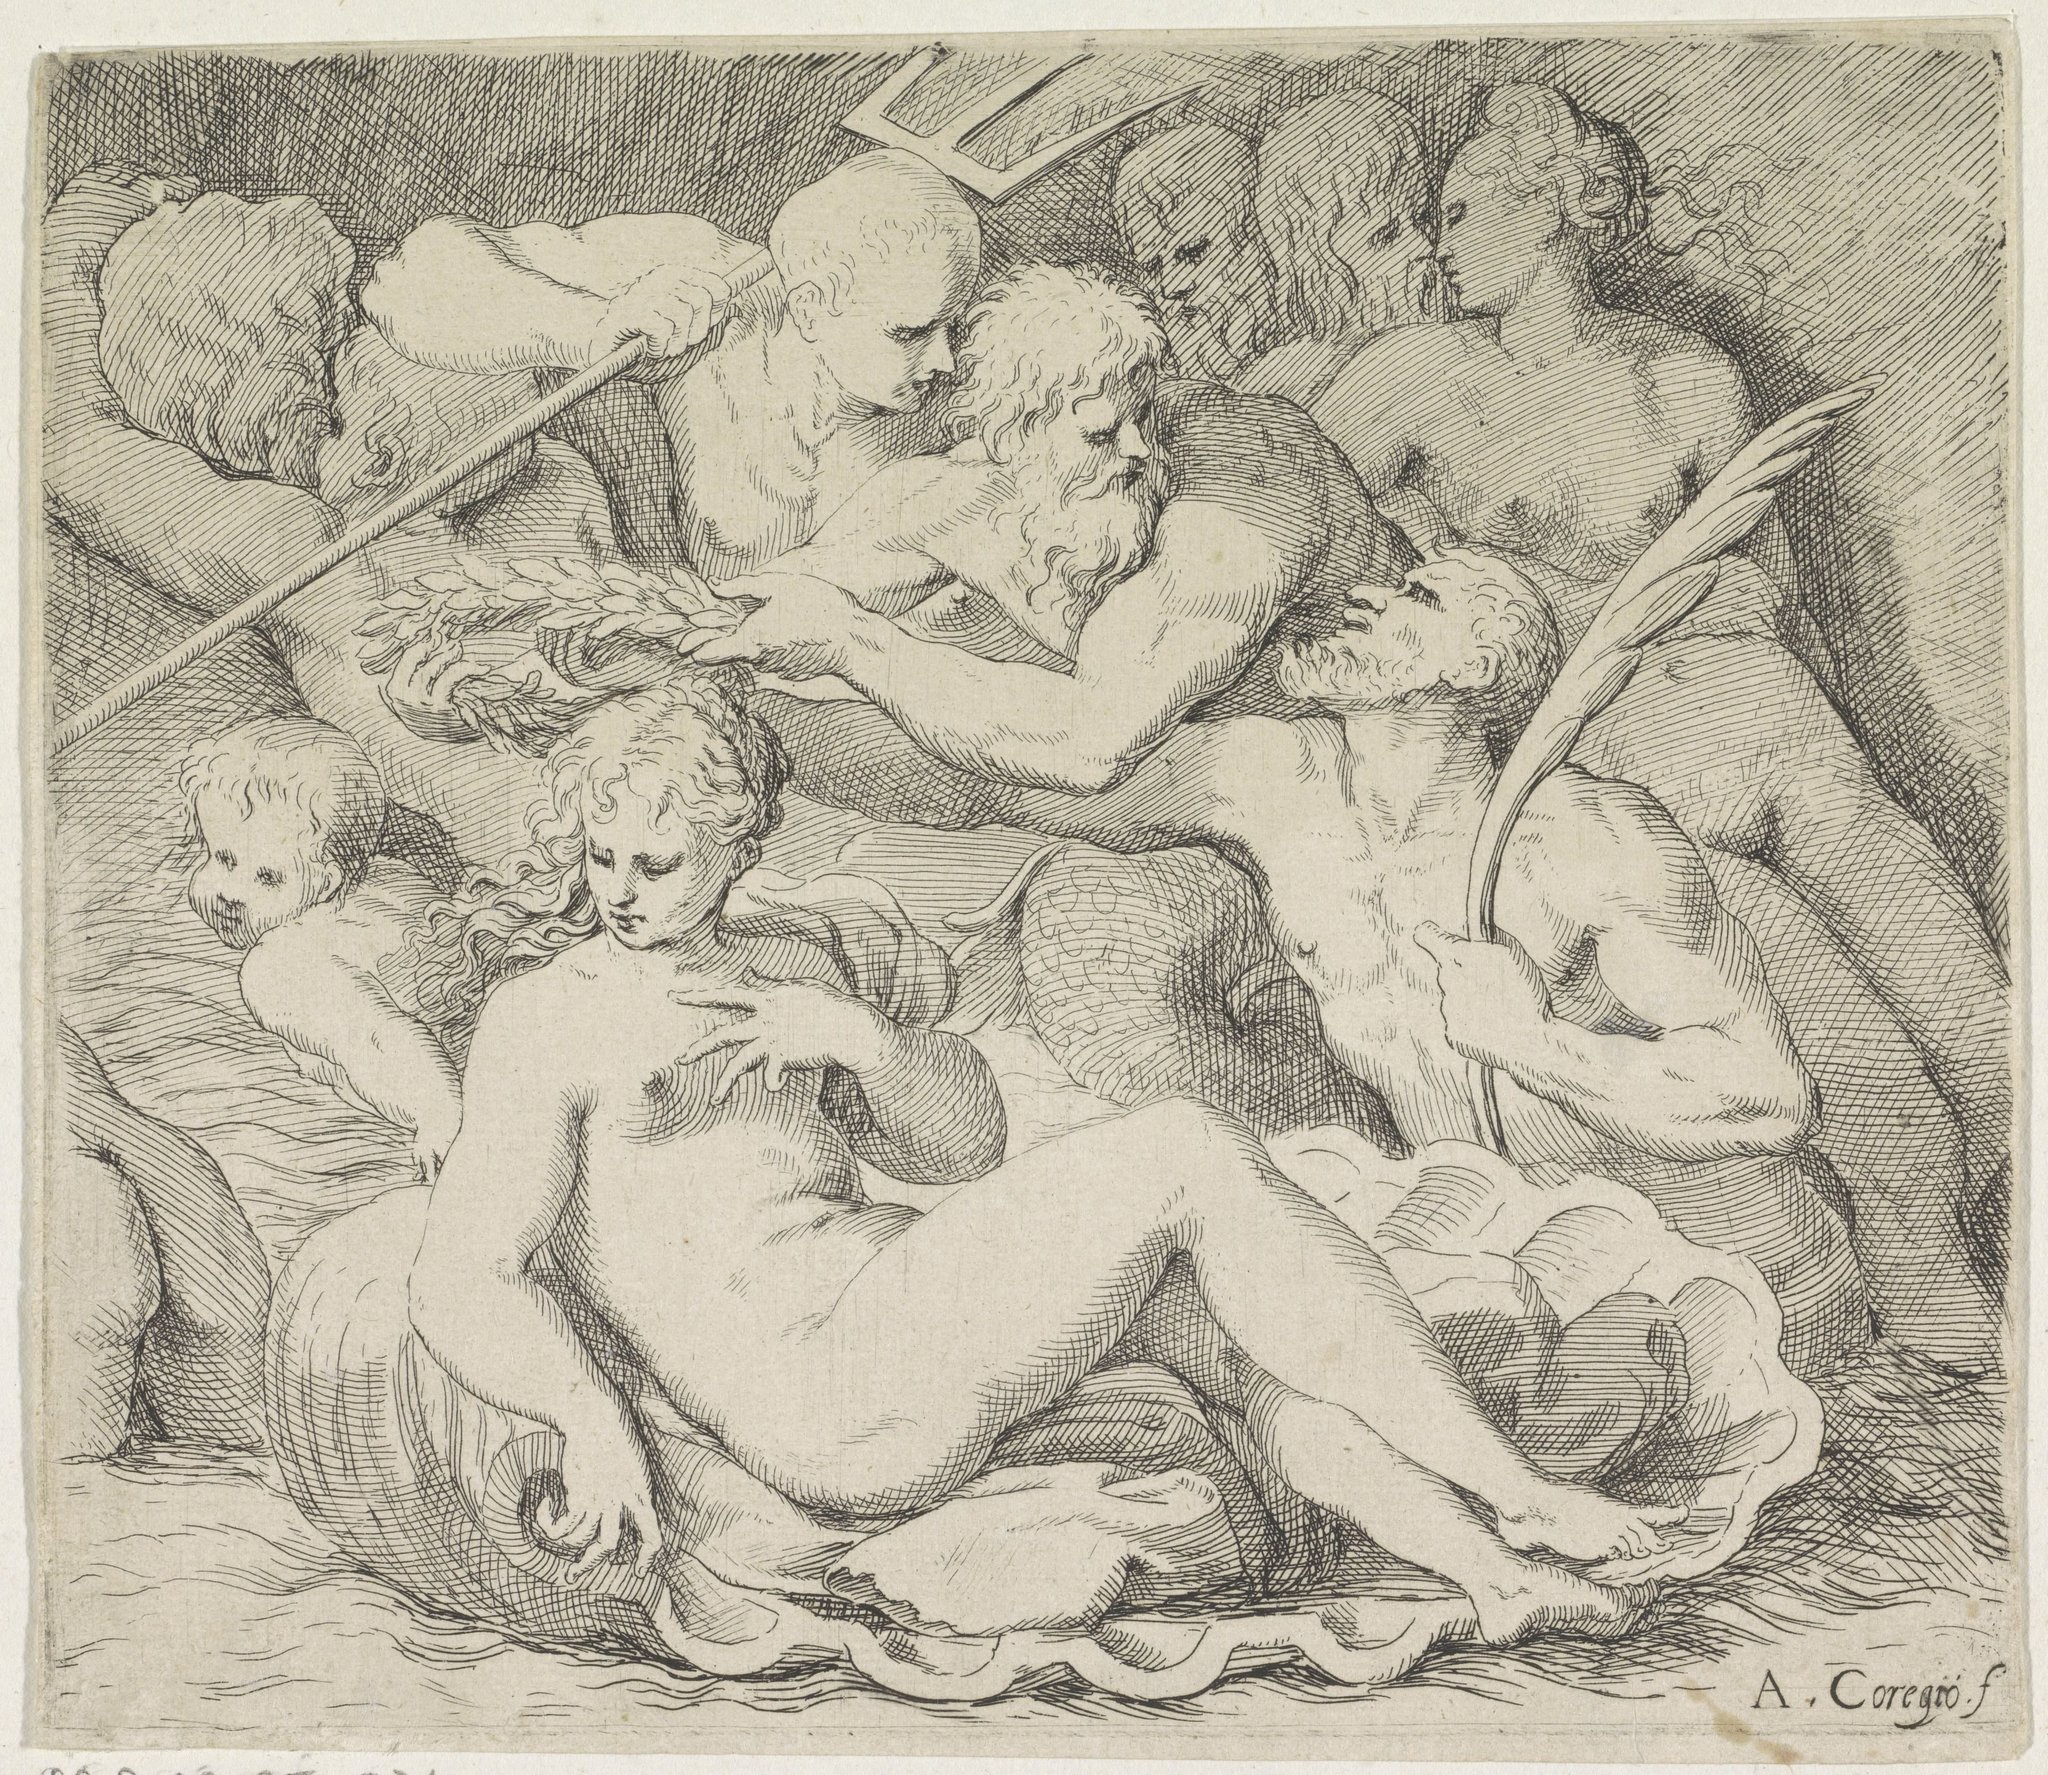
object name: print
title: Venus wordt gelauwerd door goden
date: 1510-1530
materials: paper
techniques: etching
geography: italy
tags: (story of) neptune (poseidon), (story of) venus (aphrodite)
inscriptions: collector's mark: Lugt 240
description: Venus ligt naakt op een grote schelp. Ze wordt omringd door goden die een lauwerkrans op haar hoofd zetten.